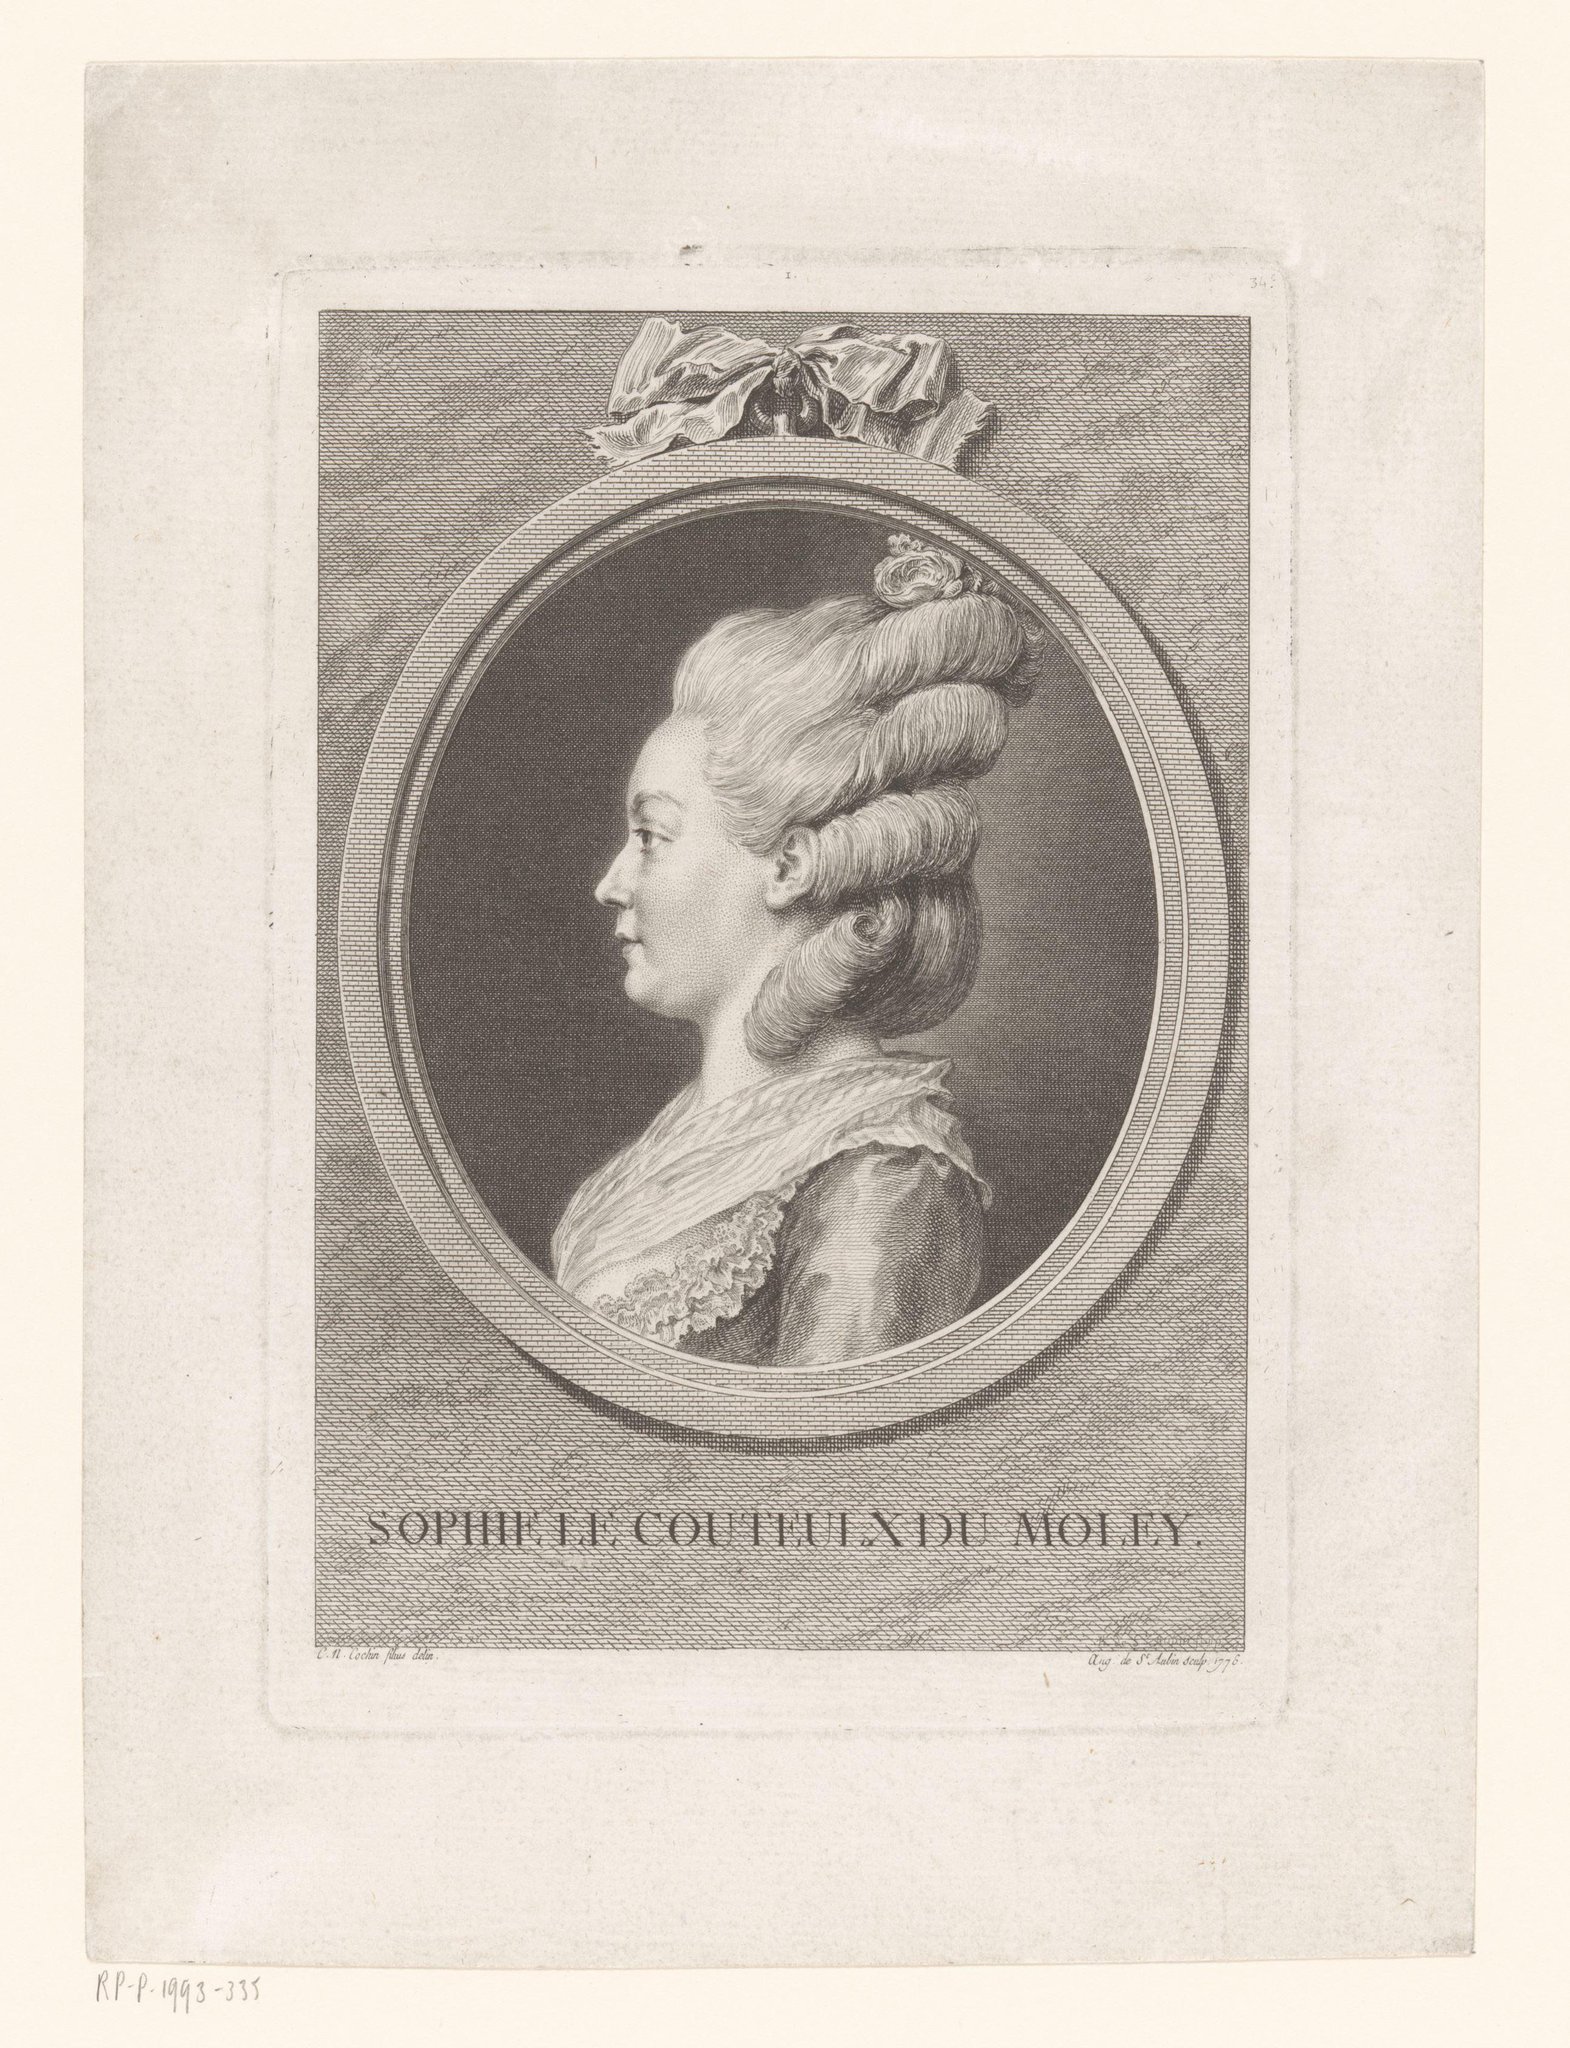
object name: print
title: Portret van Sophie Geneviève Le Couteulx du Molay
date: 1776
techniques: engraving, etching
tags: paris, adult woman, historical persons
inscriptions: collector's mark: Lugt 2228